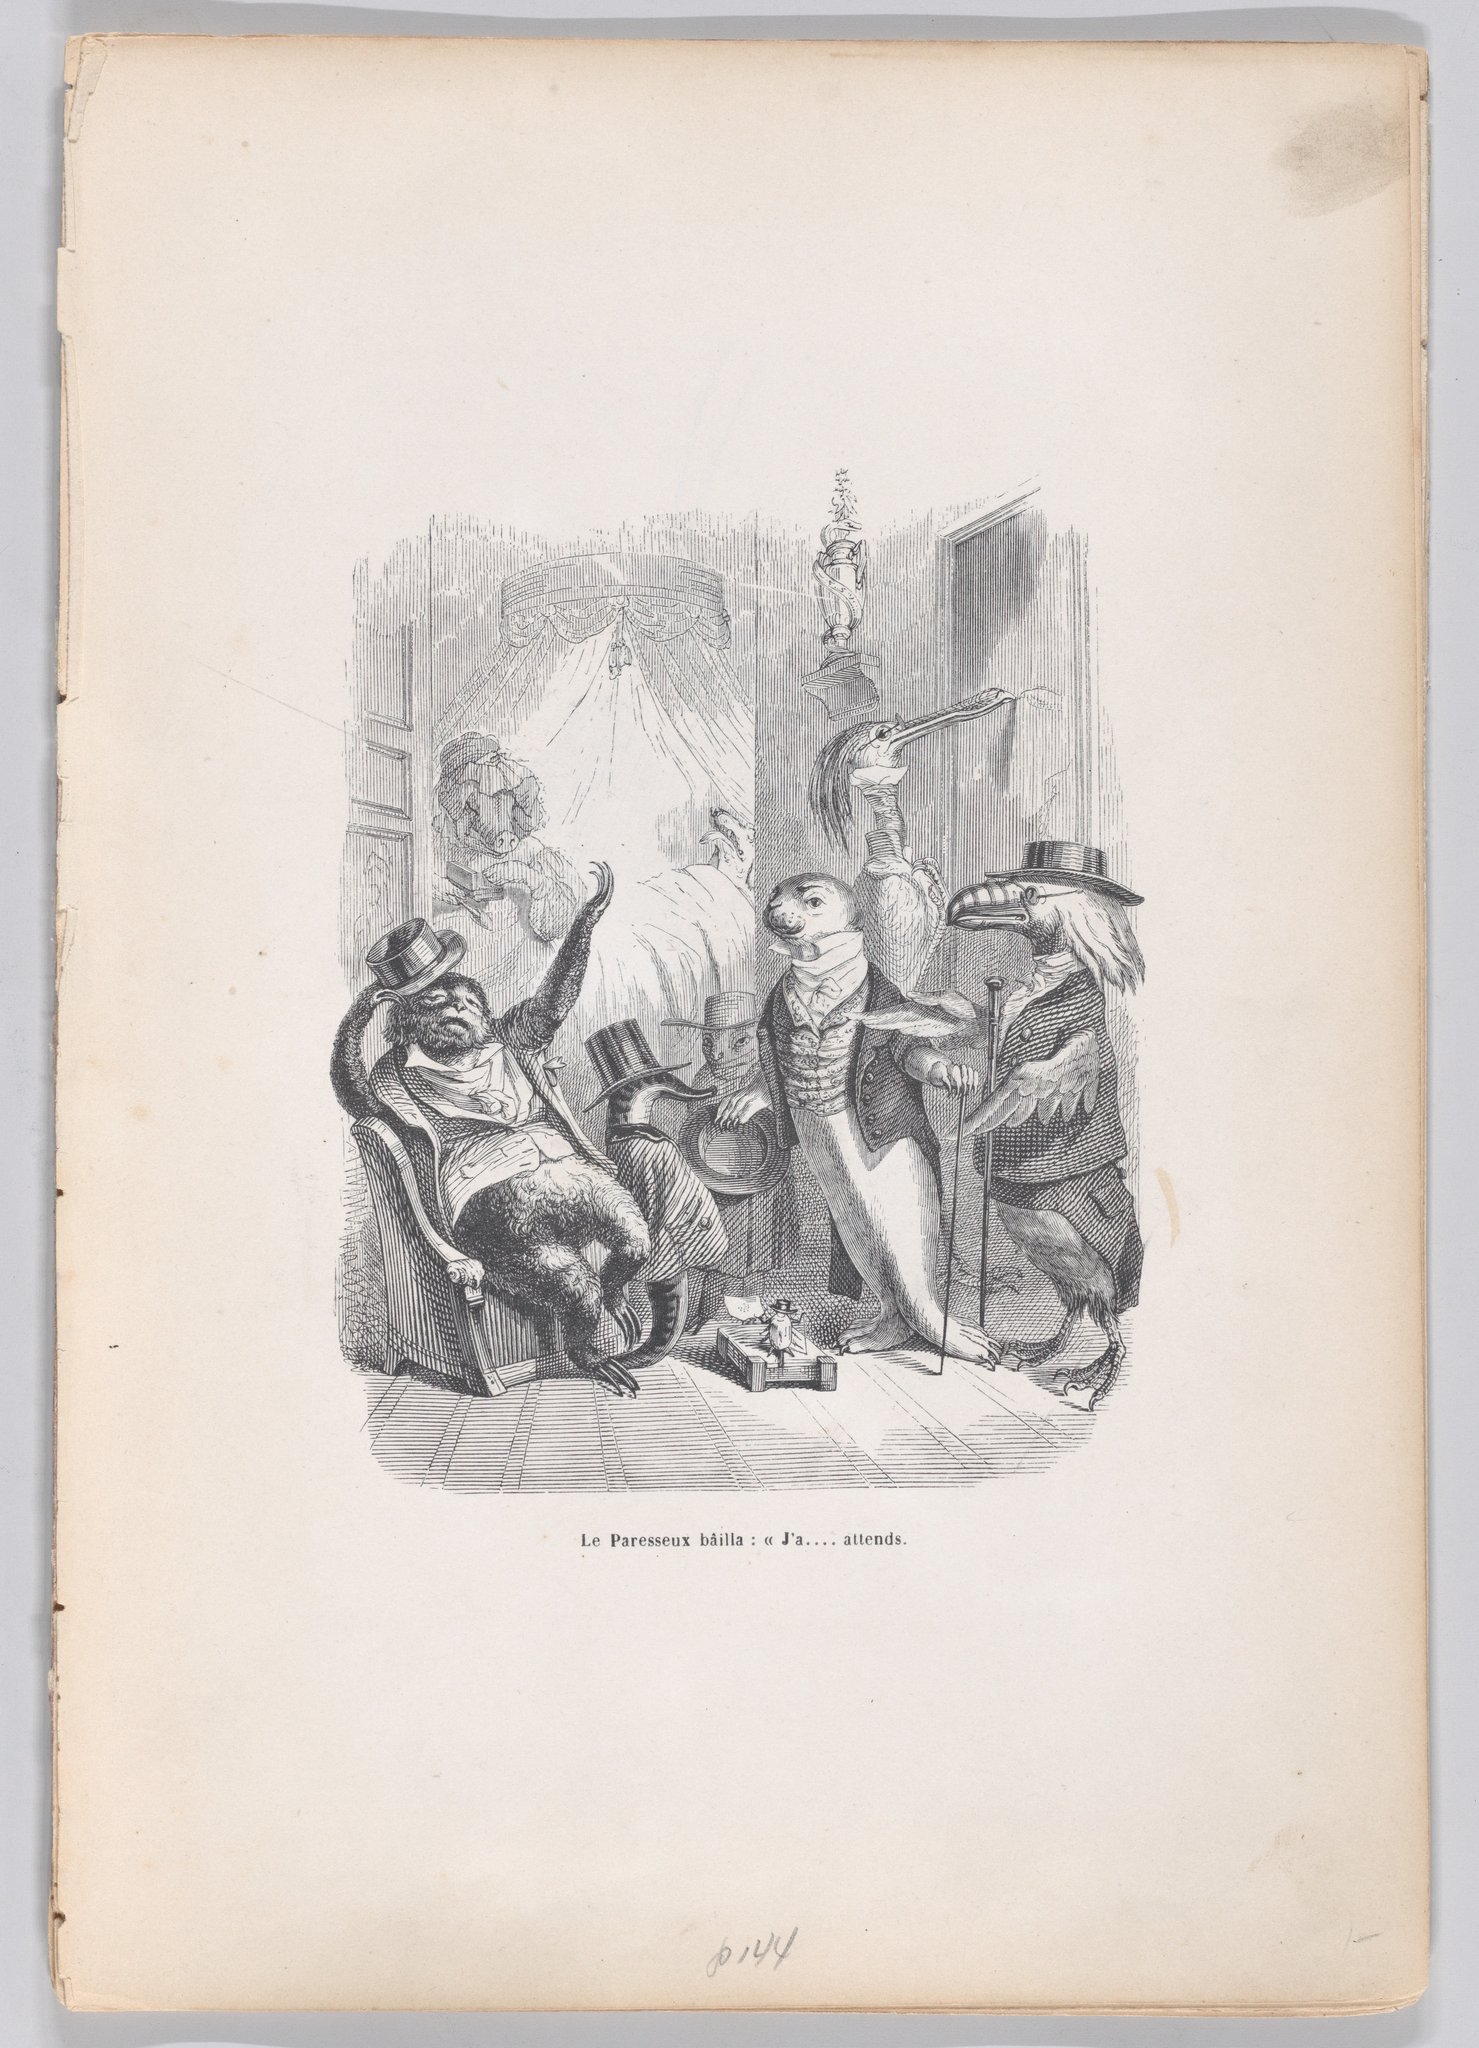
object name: print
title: The Sloth yawned: 'I had...waited', from "Scenes from the Private and Public Life of Animals"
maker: j. j. grandville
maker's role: illustrator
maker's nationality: french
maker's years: 1803-1847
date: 1837-1847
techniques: engraving